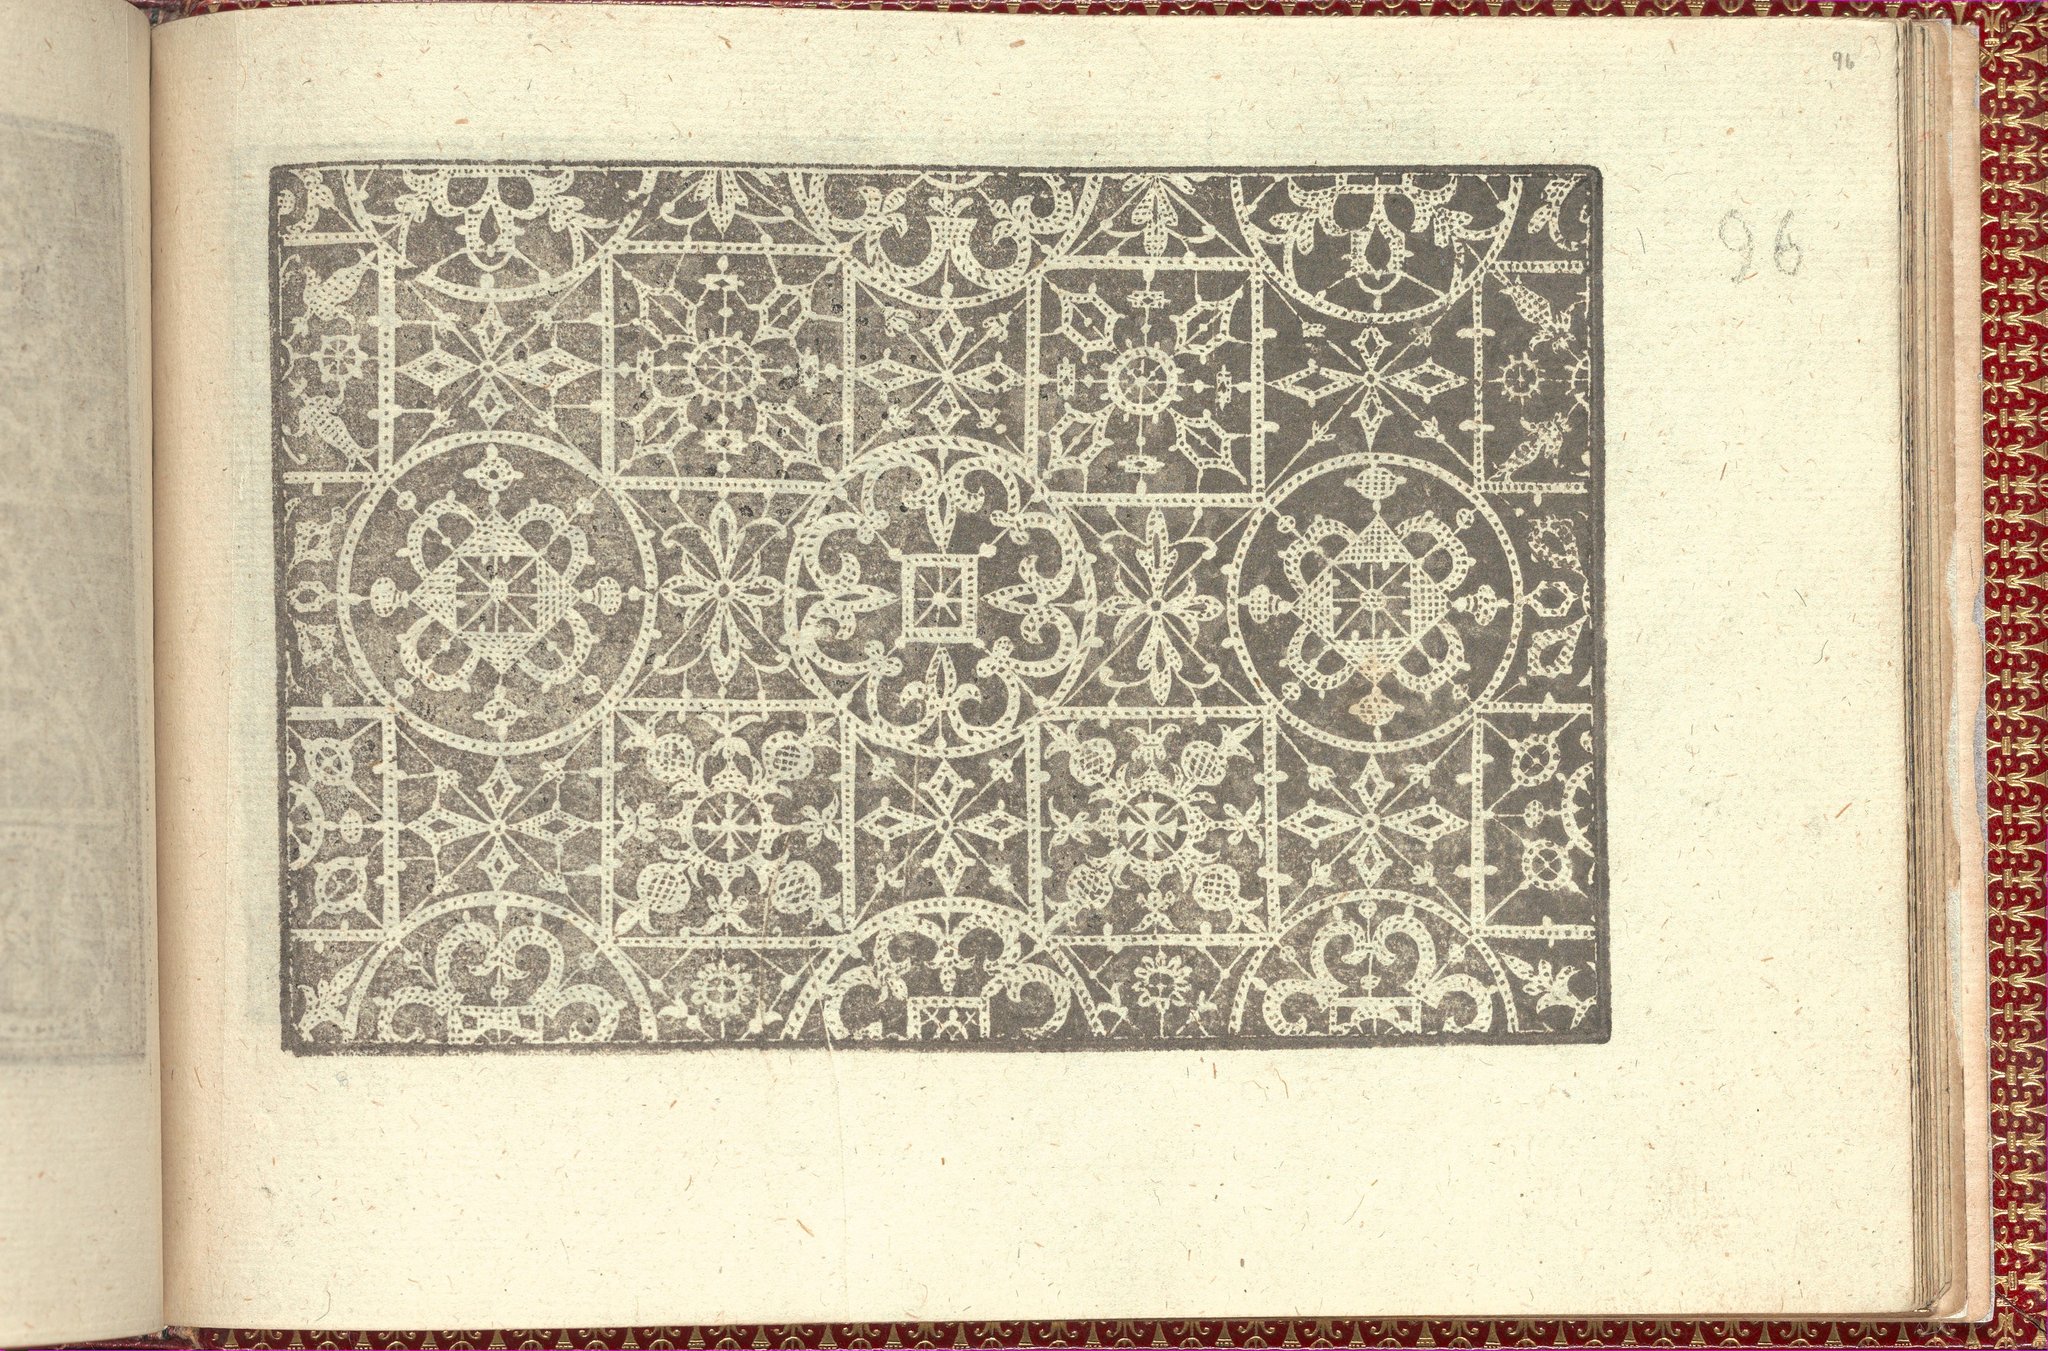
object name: book print ornament architecture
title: Corona delle Nobili et Virtuose Donne: Libro I-IV, page 96 (recto)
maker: cesare vecellio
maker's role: publisher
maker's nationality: italian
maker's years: 1521-1601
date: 1601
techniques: woodcut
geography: italy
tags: ornament